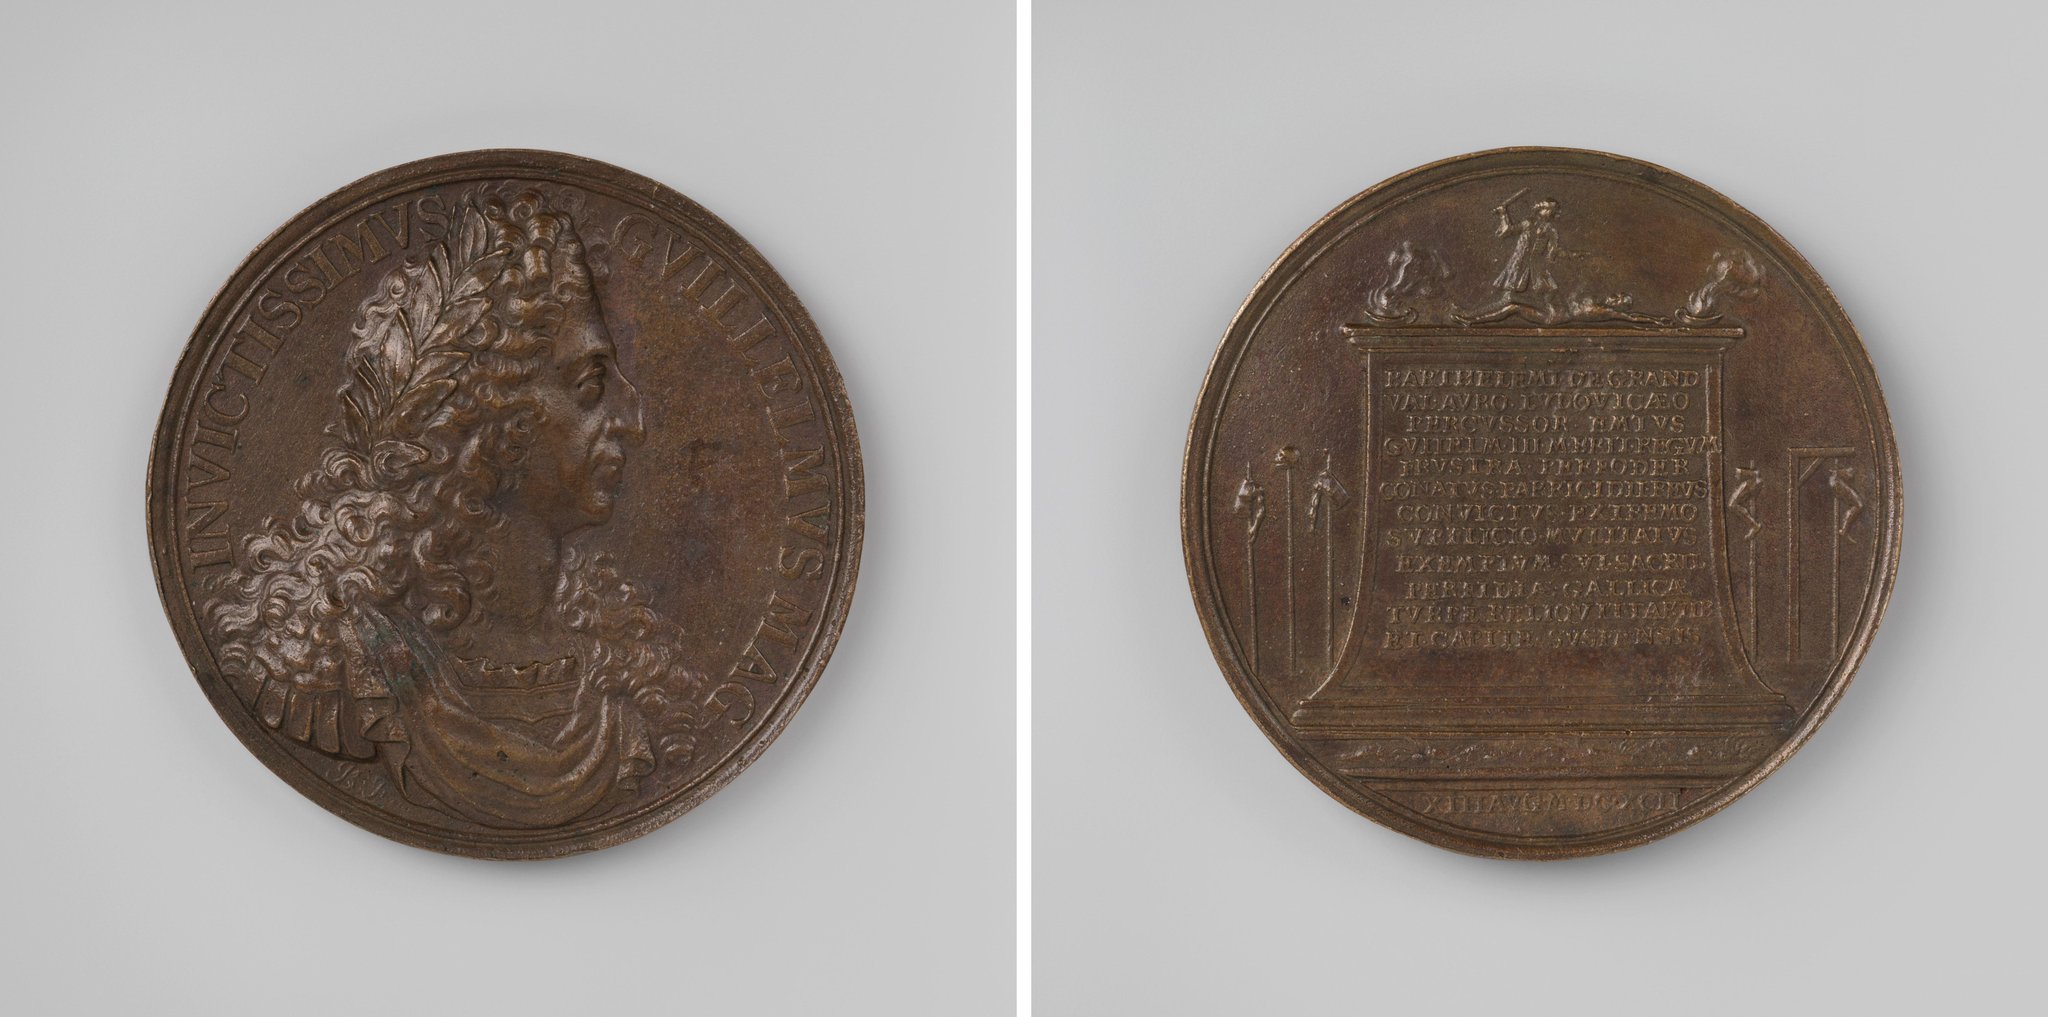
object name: history medal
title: Mislukte aanslag op het leven van Willem III en executie van Barthold Granval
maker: jan boskam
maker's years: 1687-1708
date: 1692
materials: bronze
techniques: casting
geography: nijmegen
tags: the hague, william iii (prince of orange and king of england, scotland, and ireland)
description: Bronzen penning. Voorzijde: borststuk man met lauwerkrans binnen omschrift. Keerzijde: monument met opschrift waarop beul een misdadiger martelt, aan weerszijden lichaamsdelen aan spiezen boven opschrift; afsnede: datum